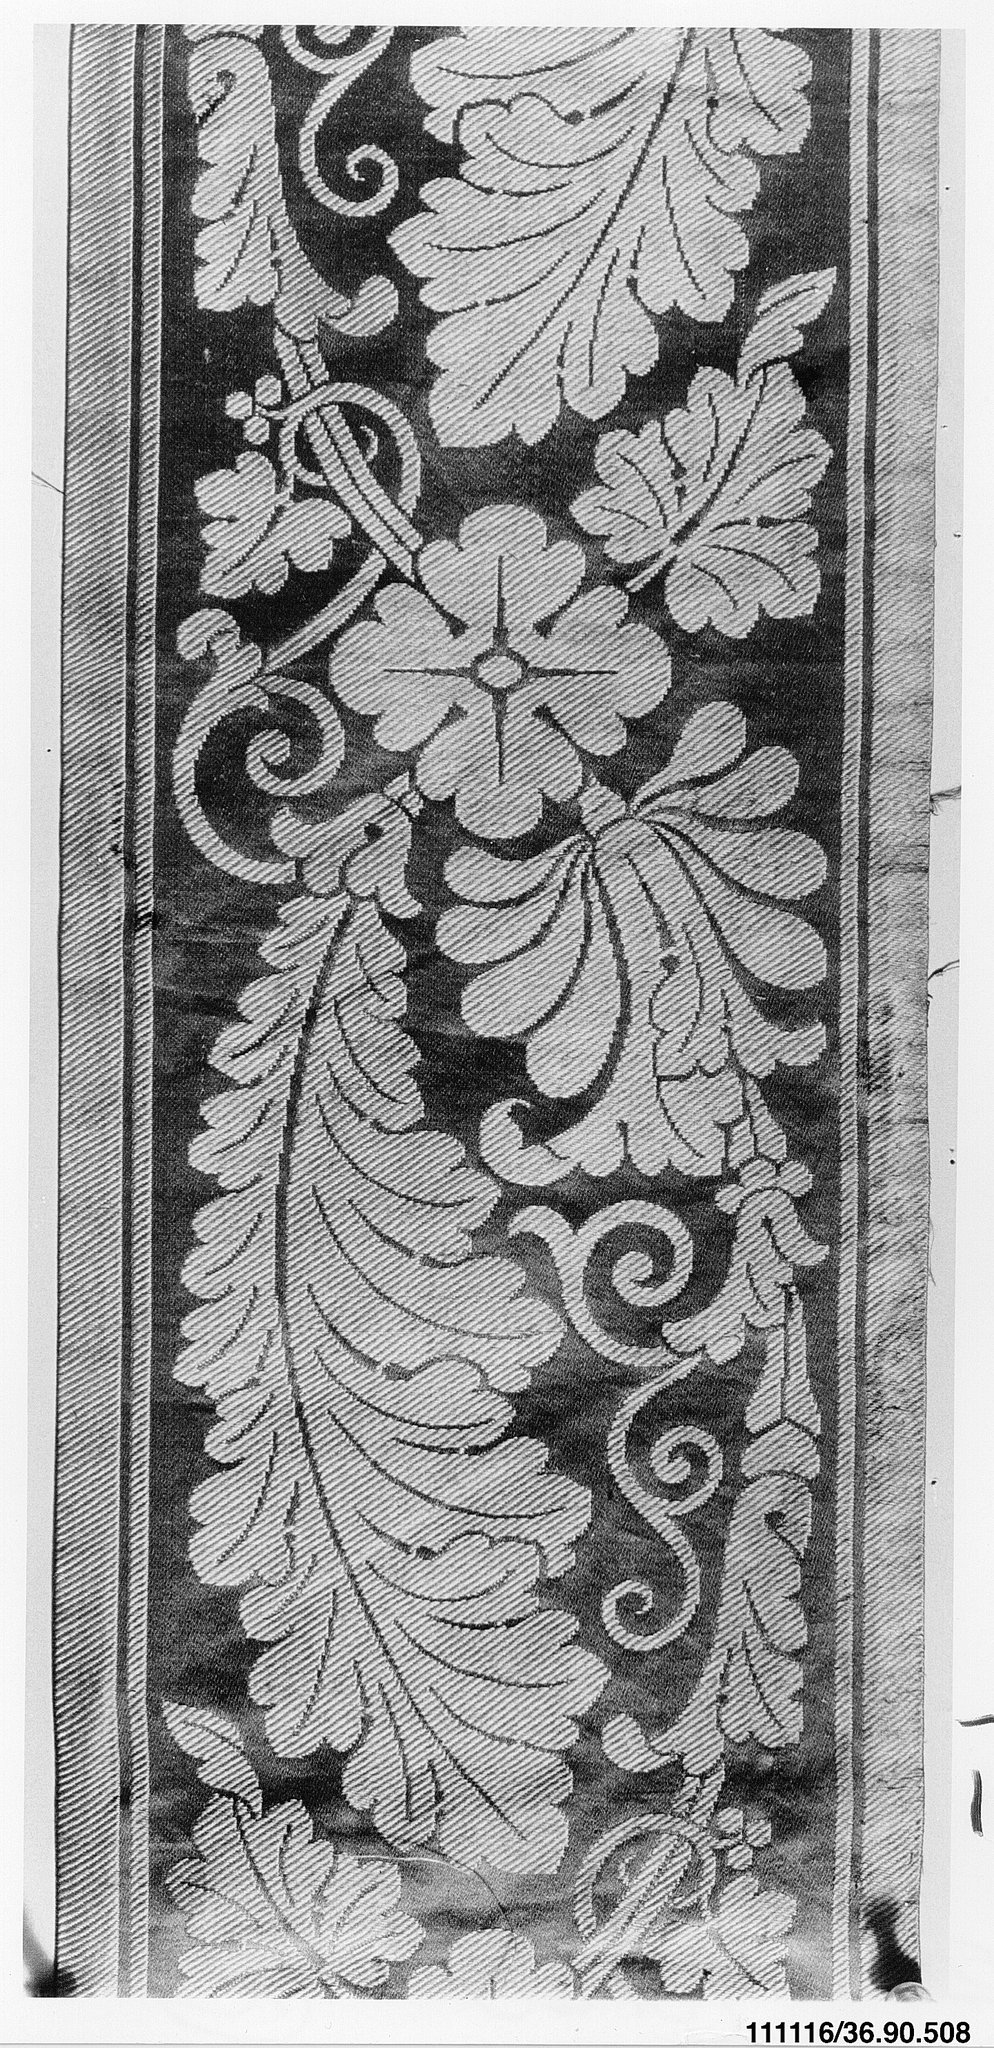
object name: piece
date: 1801-1833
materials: silk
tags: flowers,leaves